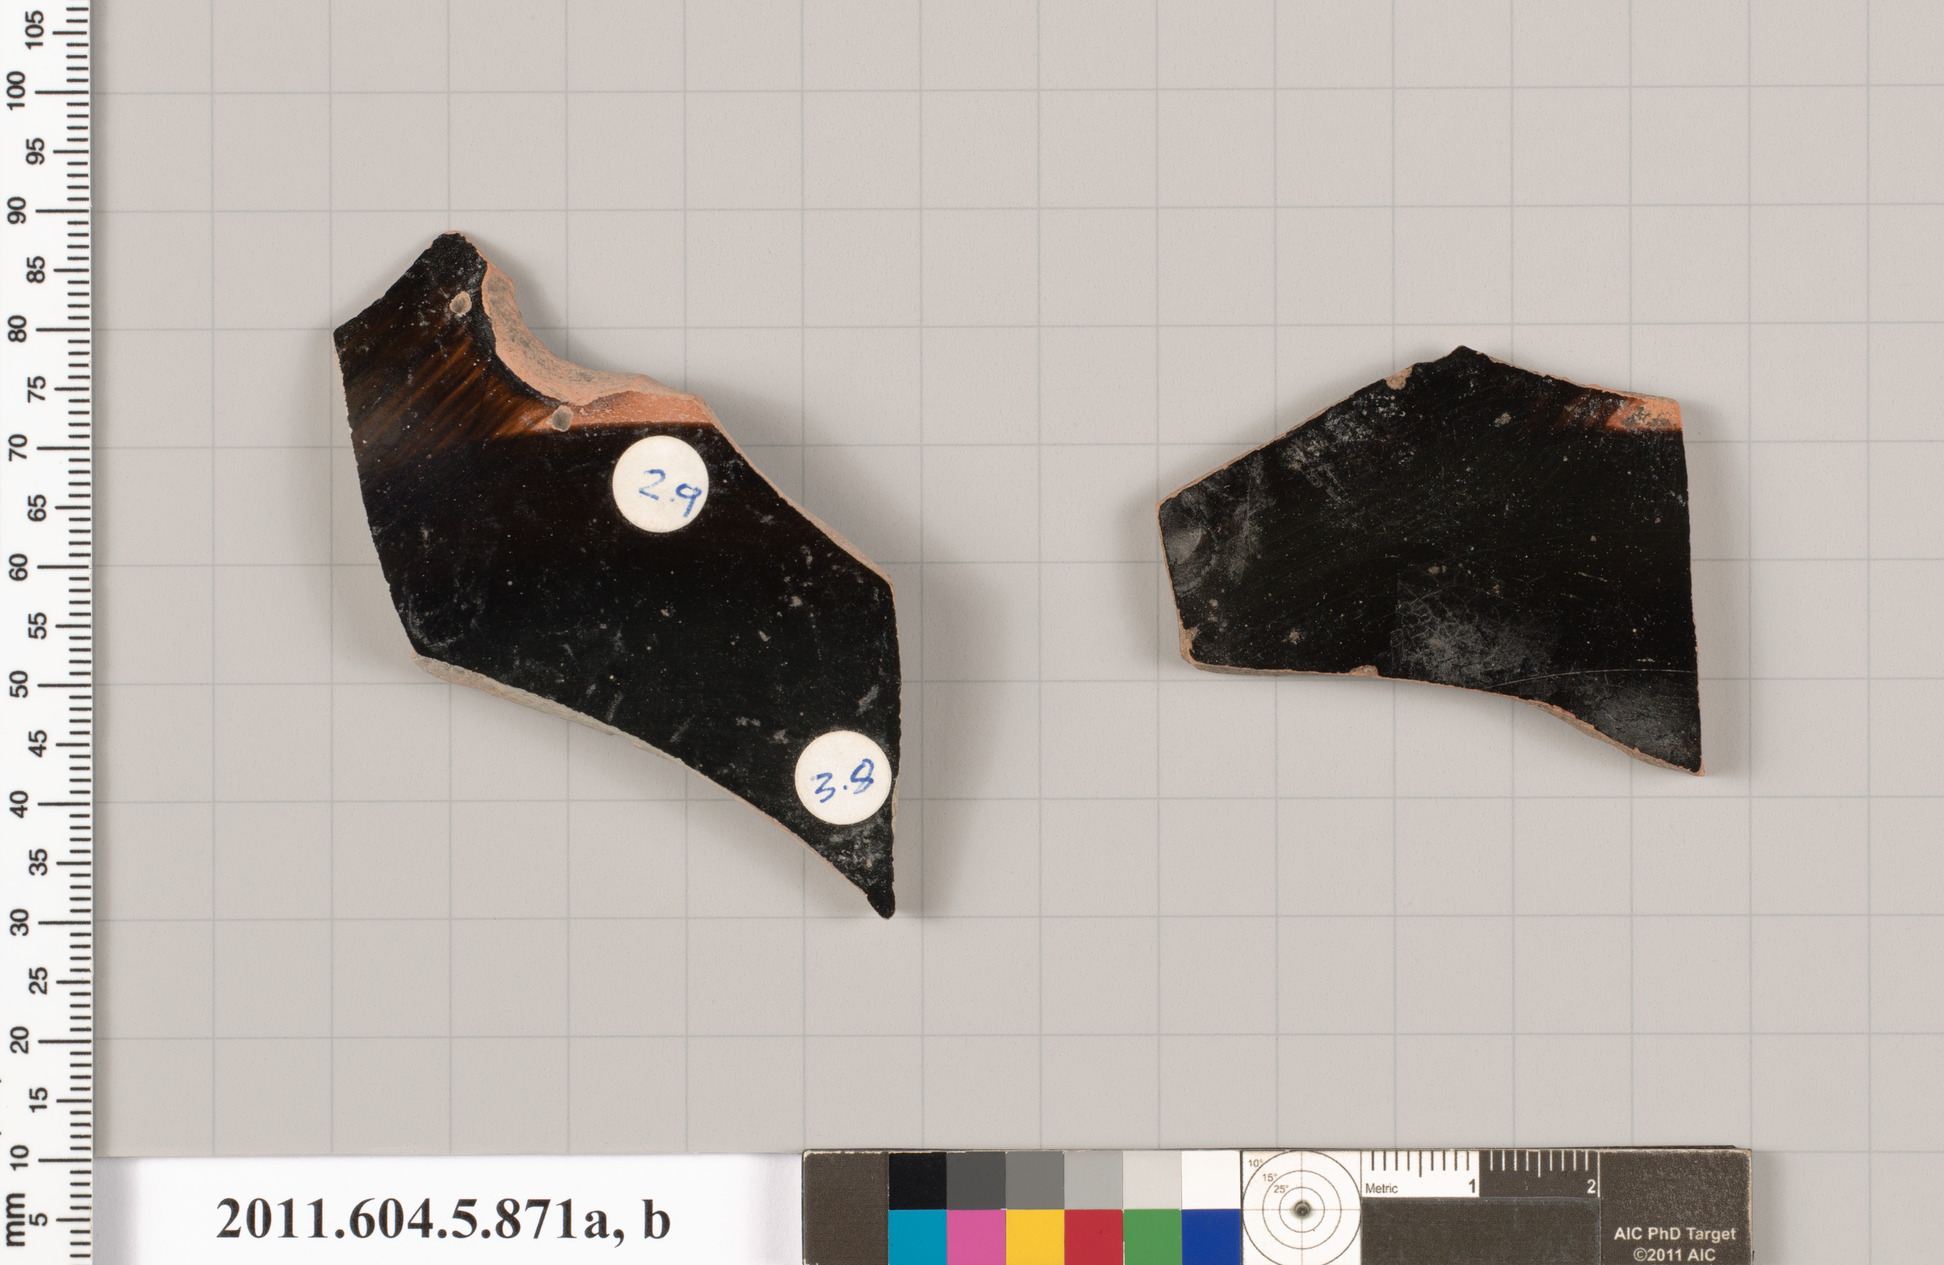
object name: kylix fragment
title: Terracotta fragments of kylikes (drinking cups)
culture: greek, attic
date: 600-401 BCE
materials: terracotta